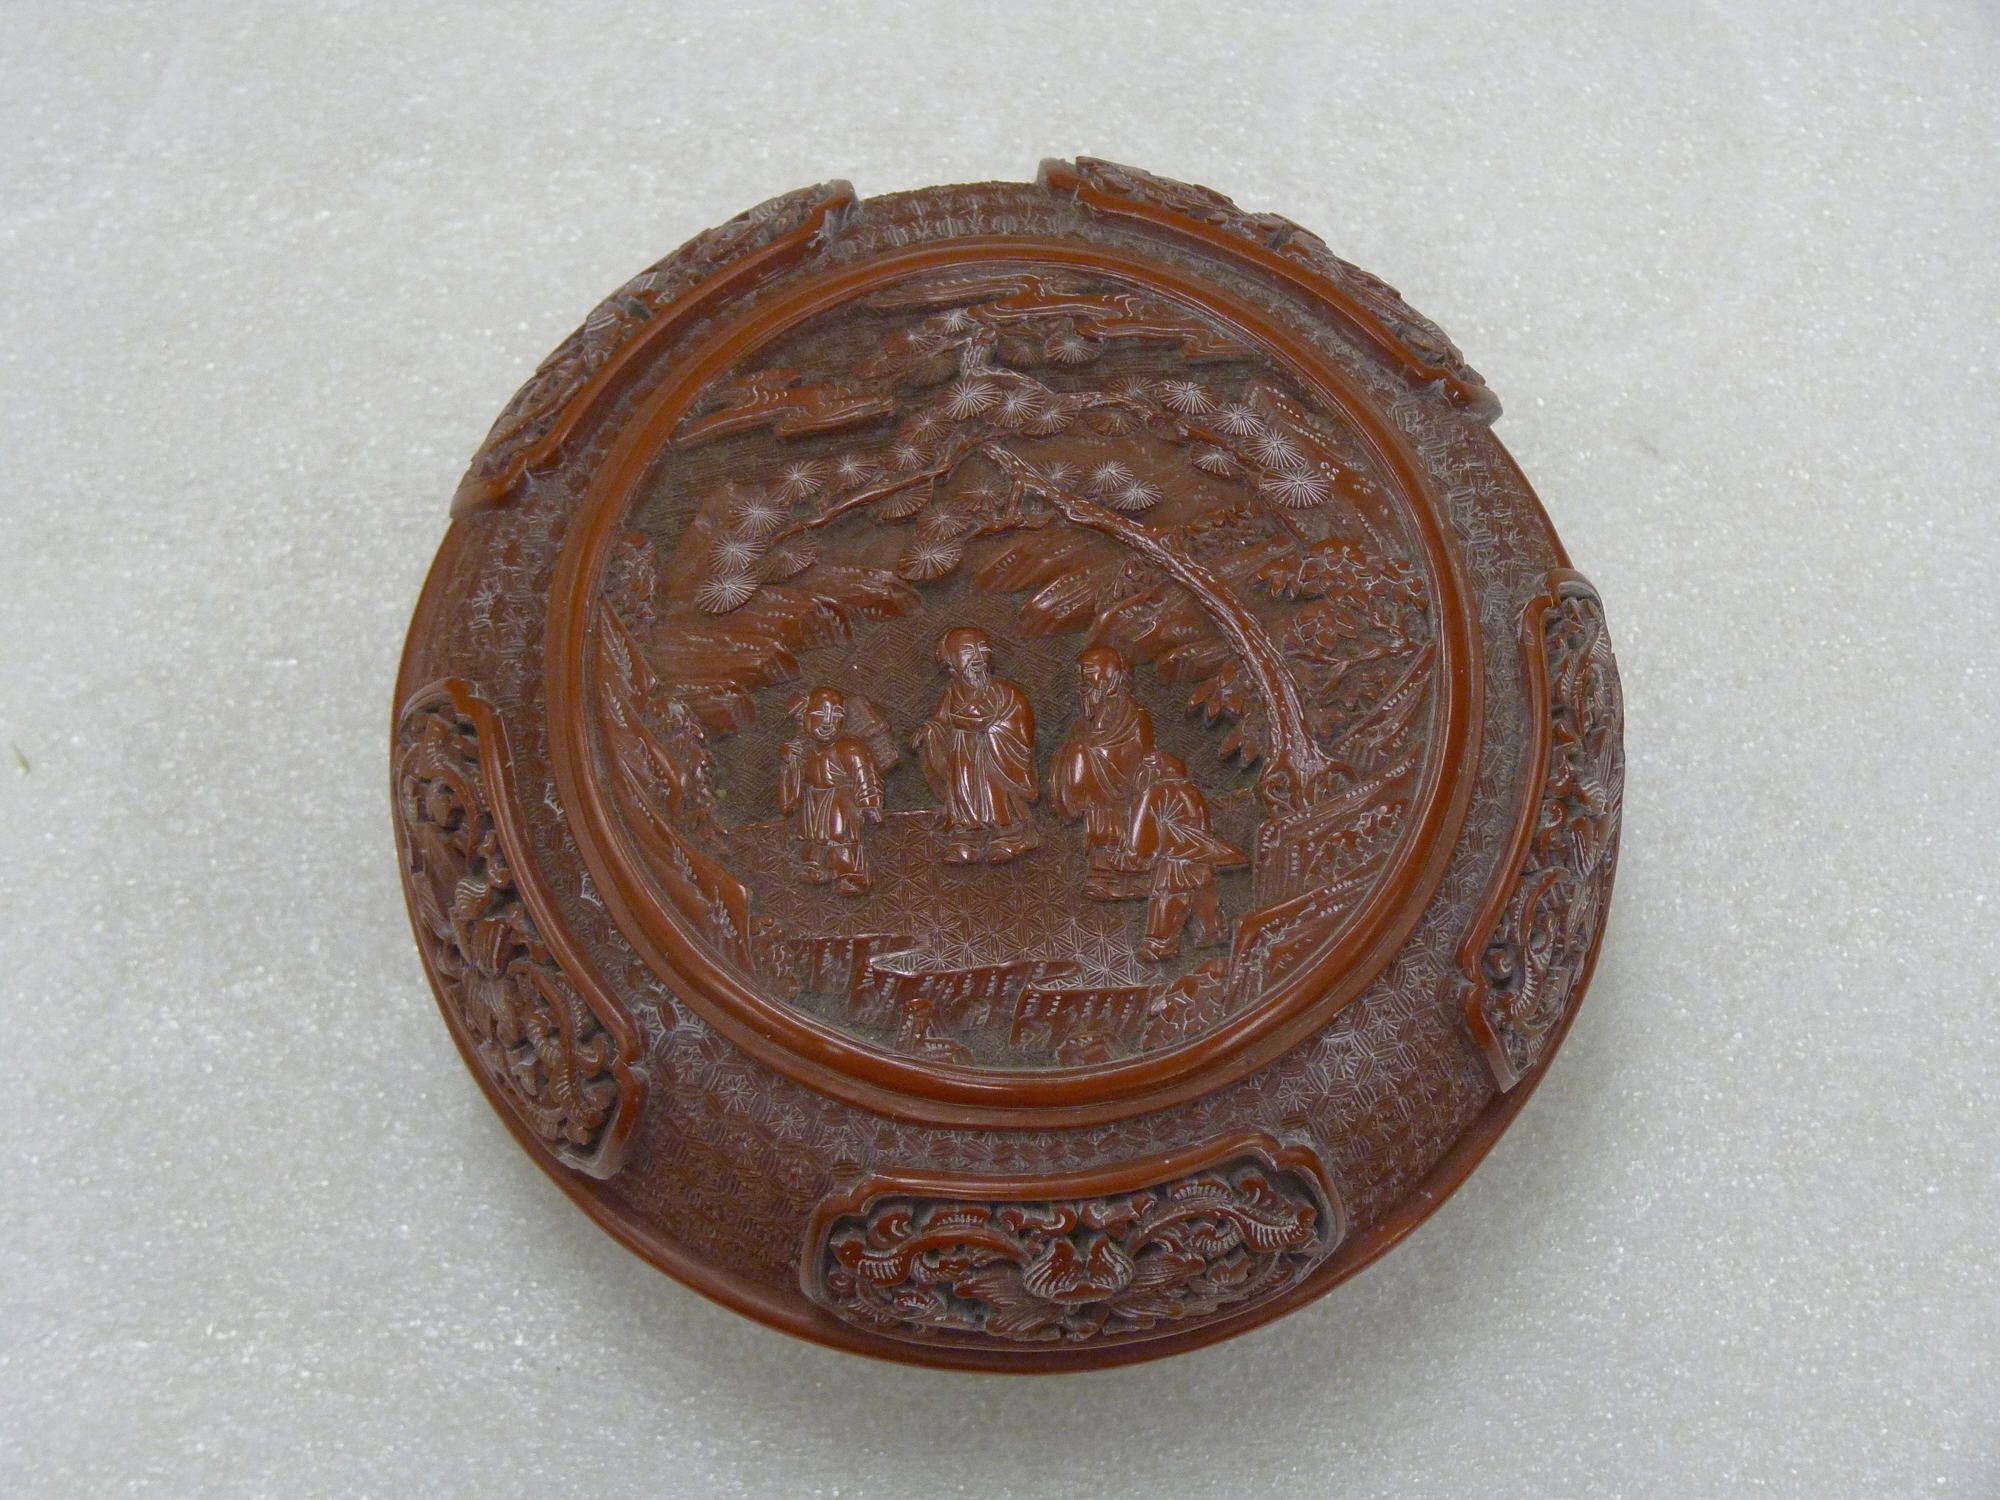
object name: box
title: Box with Cover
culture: chinese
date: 1821-1850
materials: lacquer